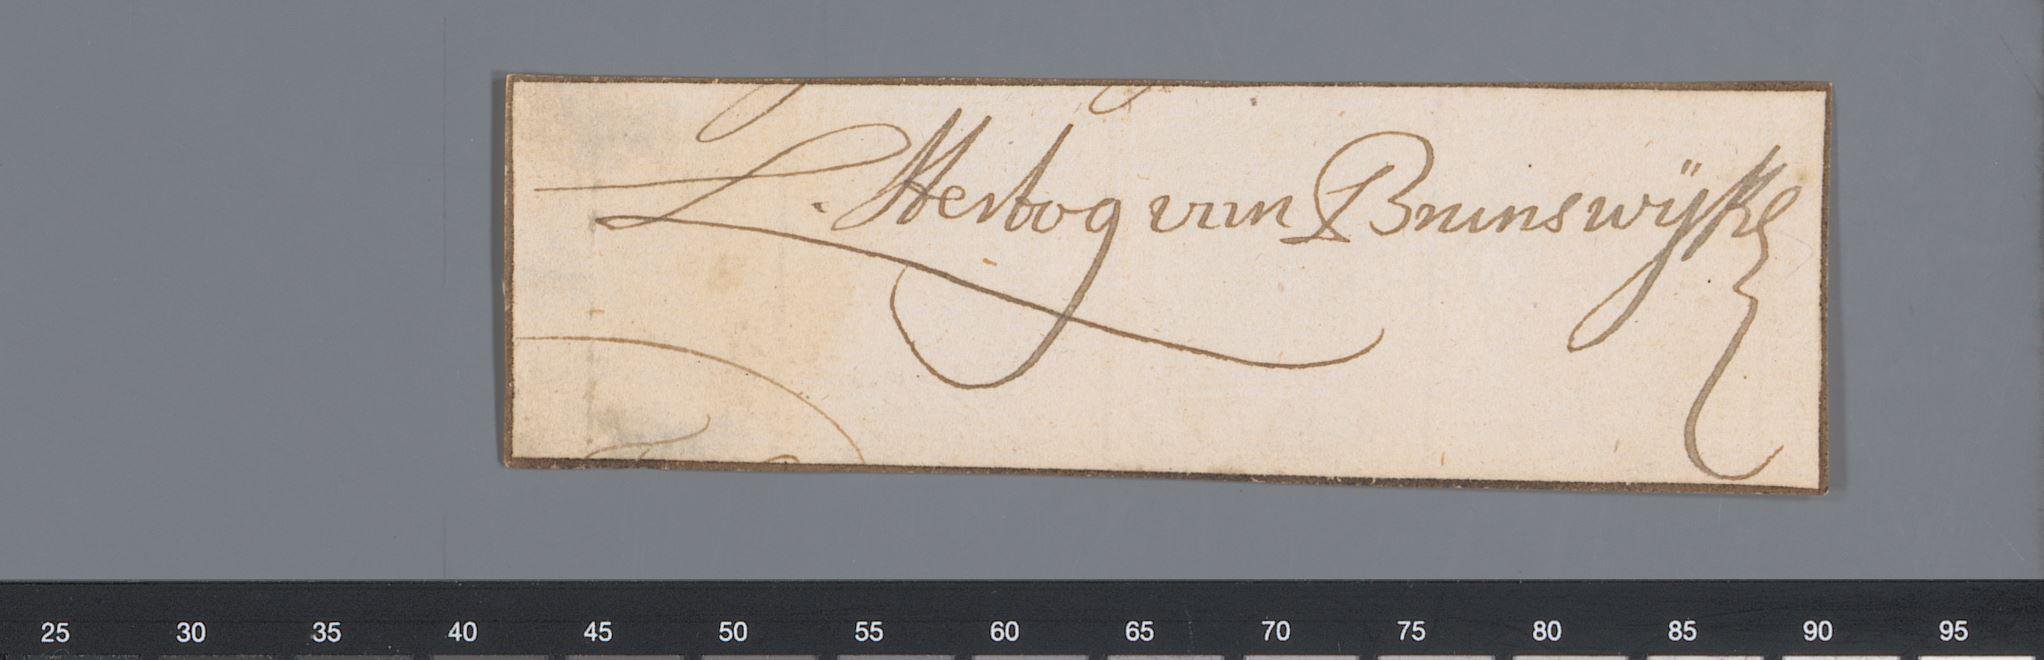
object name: document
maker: ludwig ernst von braunschweig-wolfenbüttel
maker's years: 1718-1788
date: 1720-1788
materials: ink, paper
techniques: writing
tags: ludwig ernst von braunschweig-wolfenbüttel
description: Handtekening in bruine inkt (van Lodewijk van Brunswijk), op blaadje papier. Gesigneerd: L. Hertog van Brunswijk.